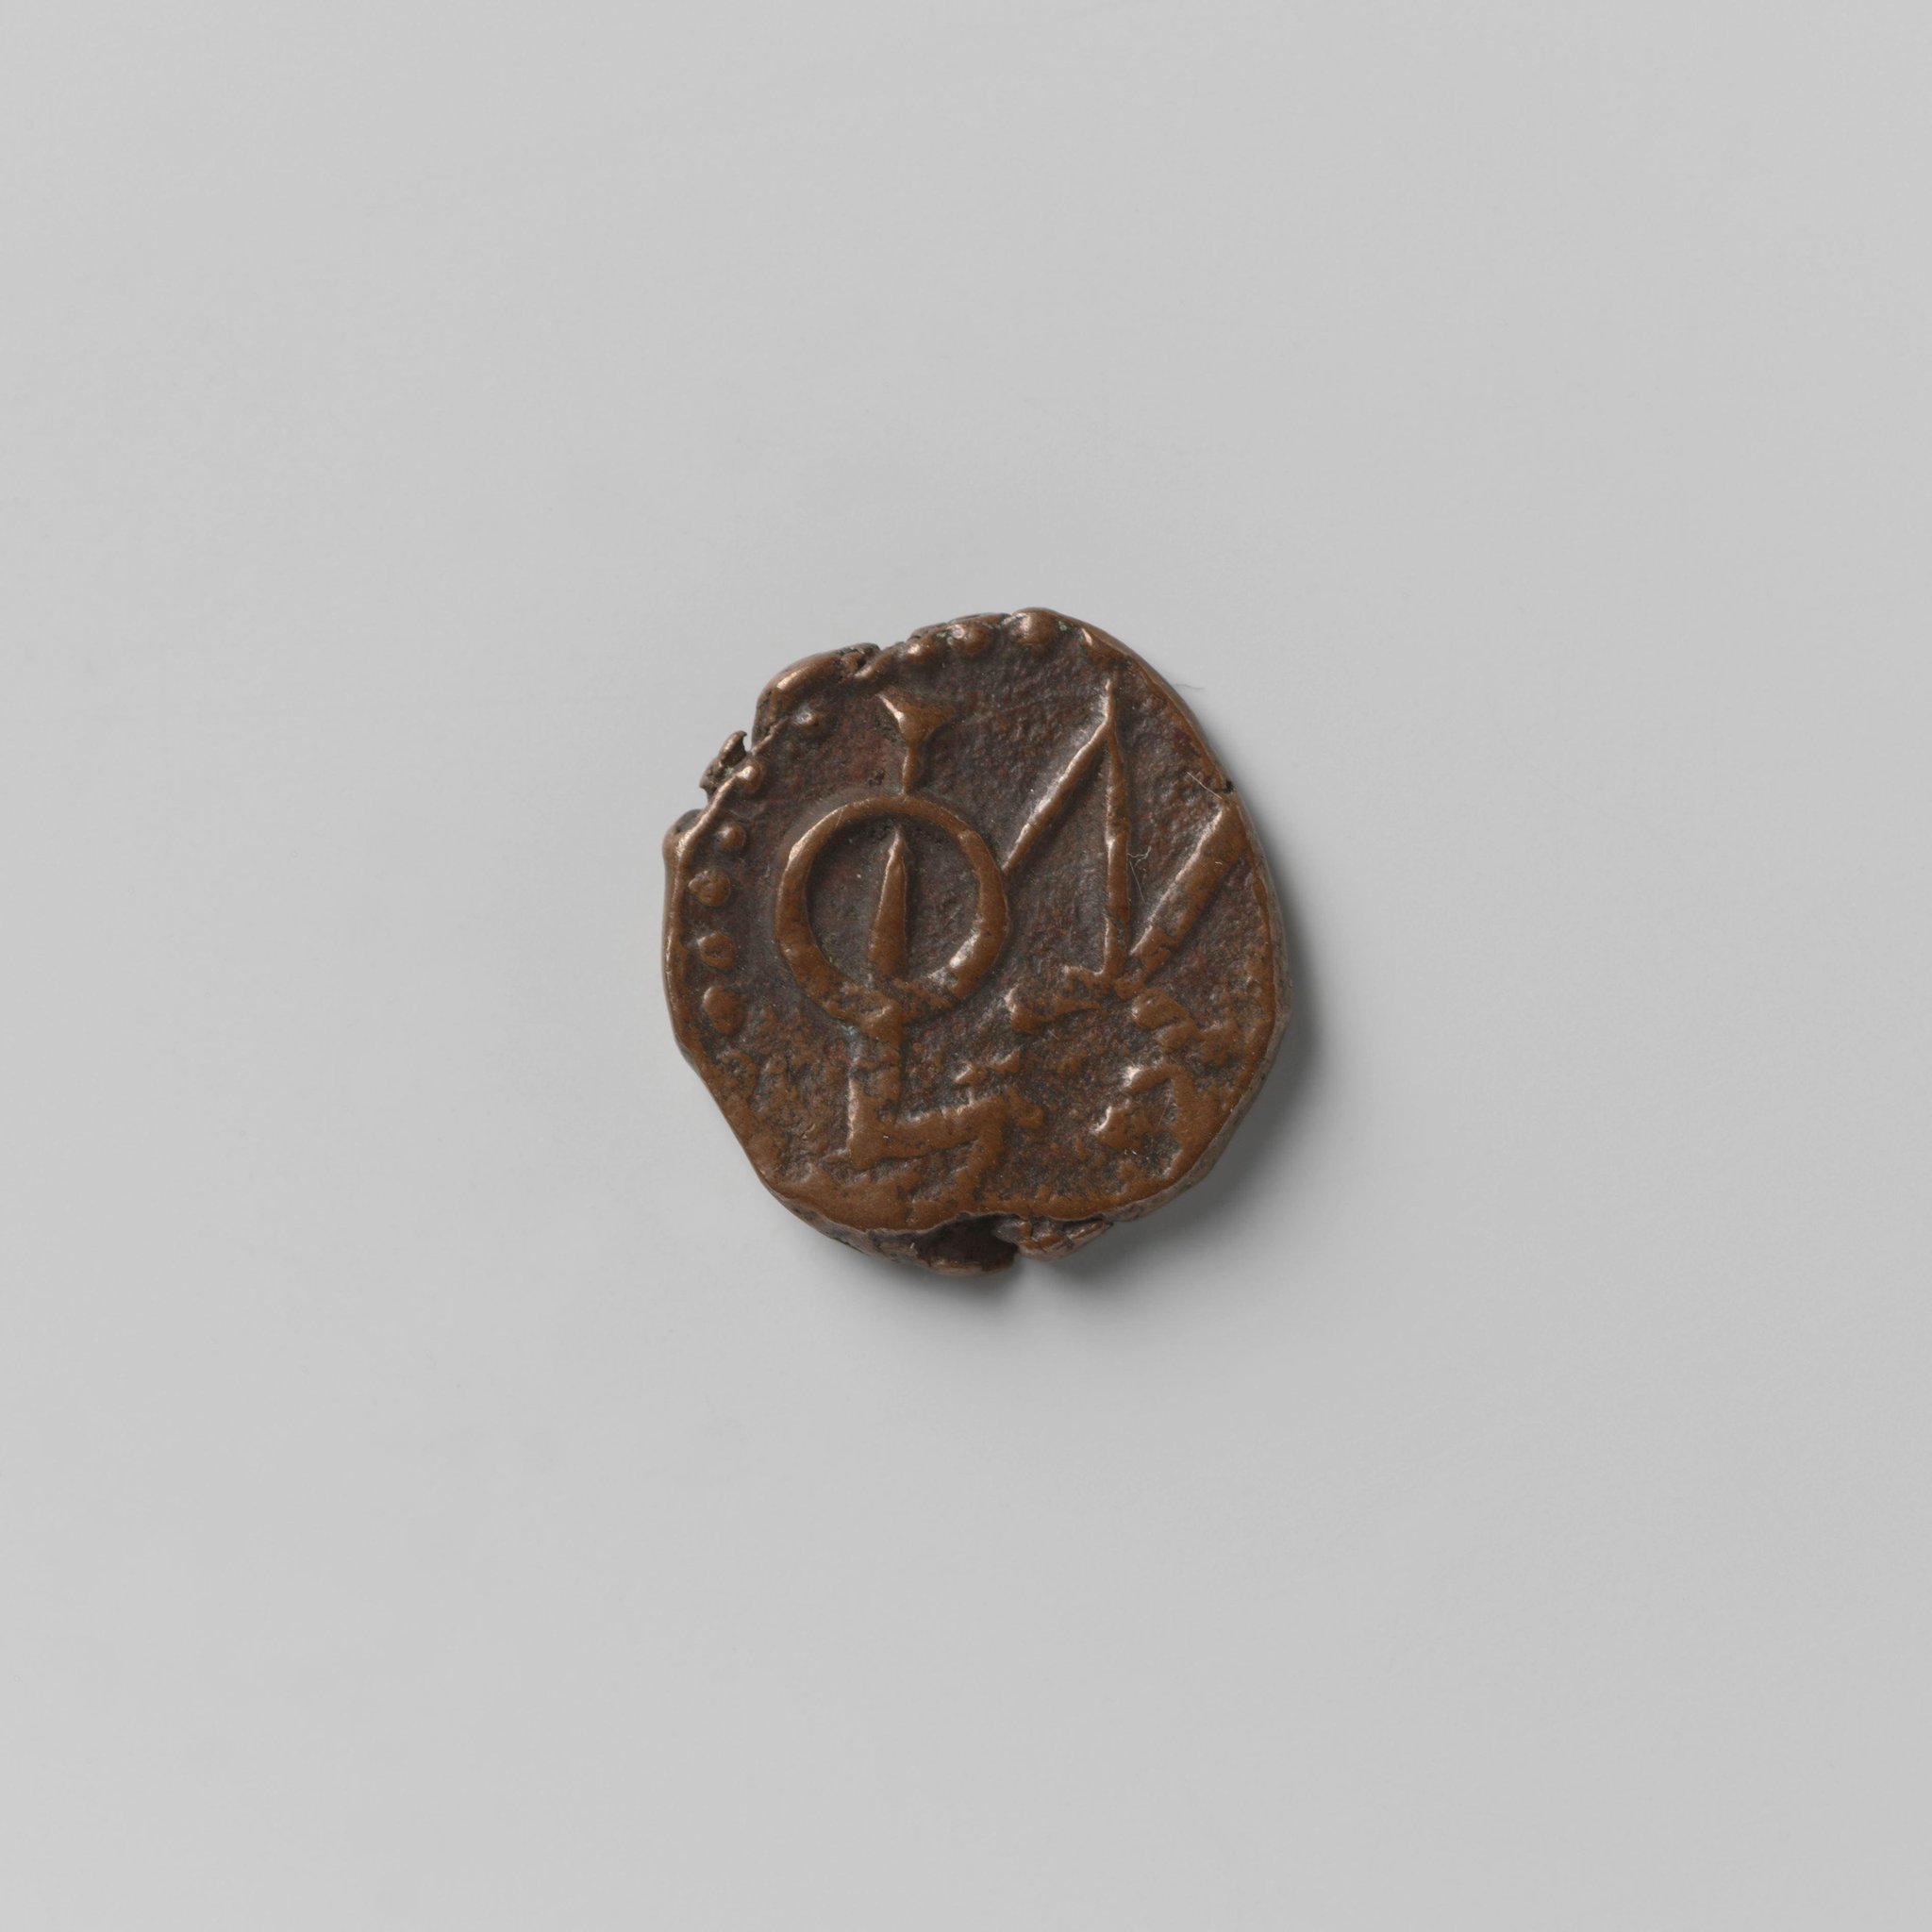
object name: coin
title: 2 kas van Negapatnam, Voor-Indië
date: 1660-1680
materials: copper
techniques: striking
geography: negapatnam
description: Koperen munt. Voorzijde: monogram van de VOC, waarboven letter N. Keerzijde: tweeregelig opschrift in het Tamil. Gladde rand.